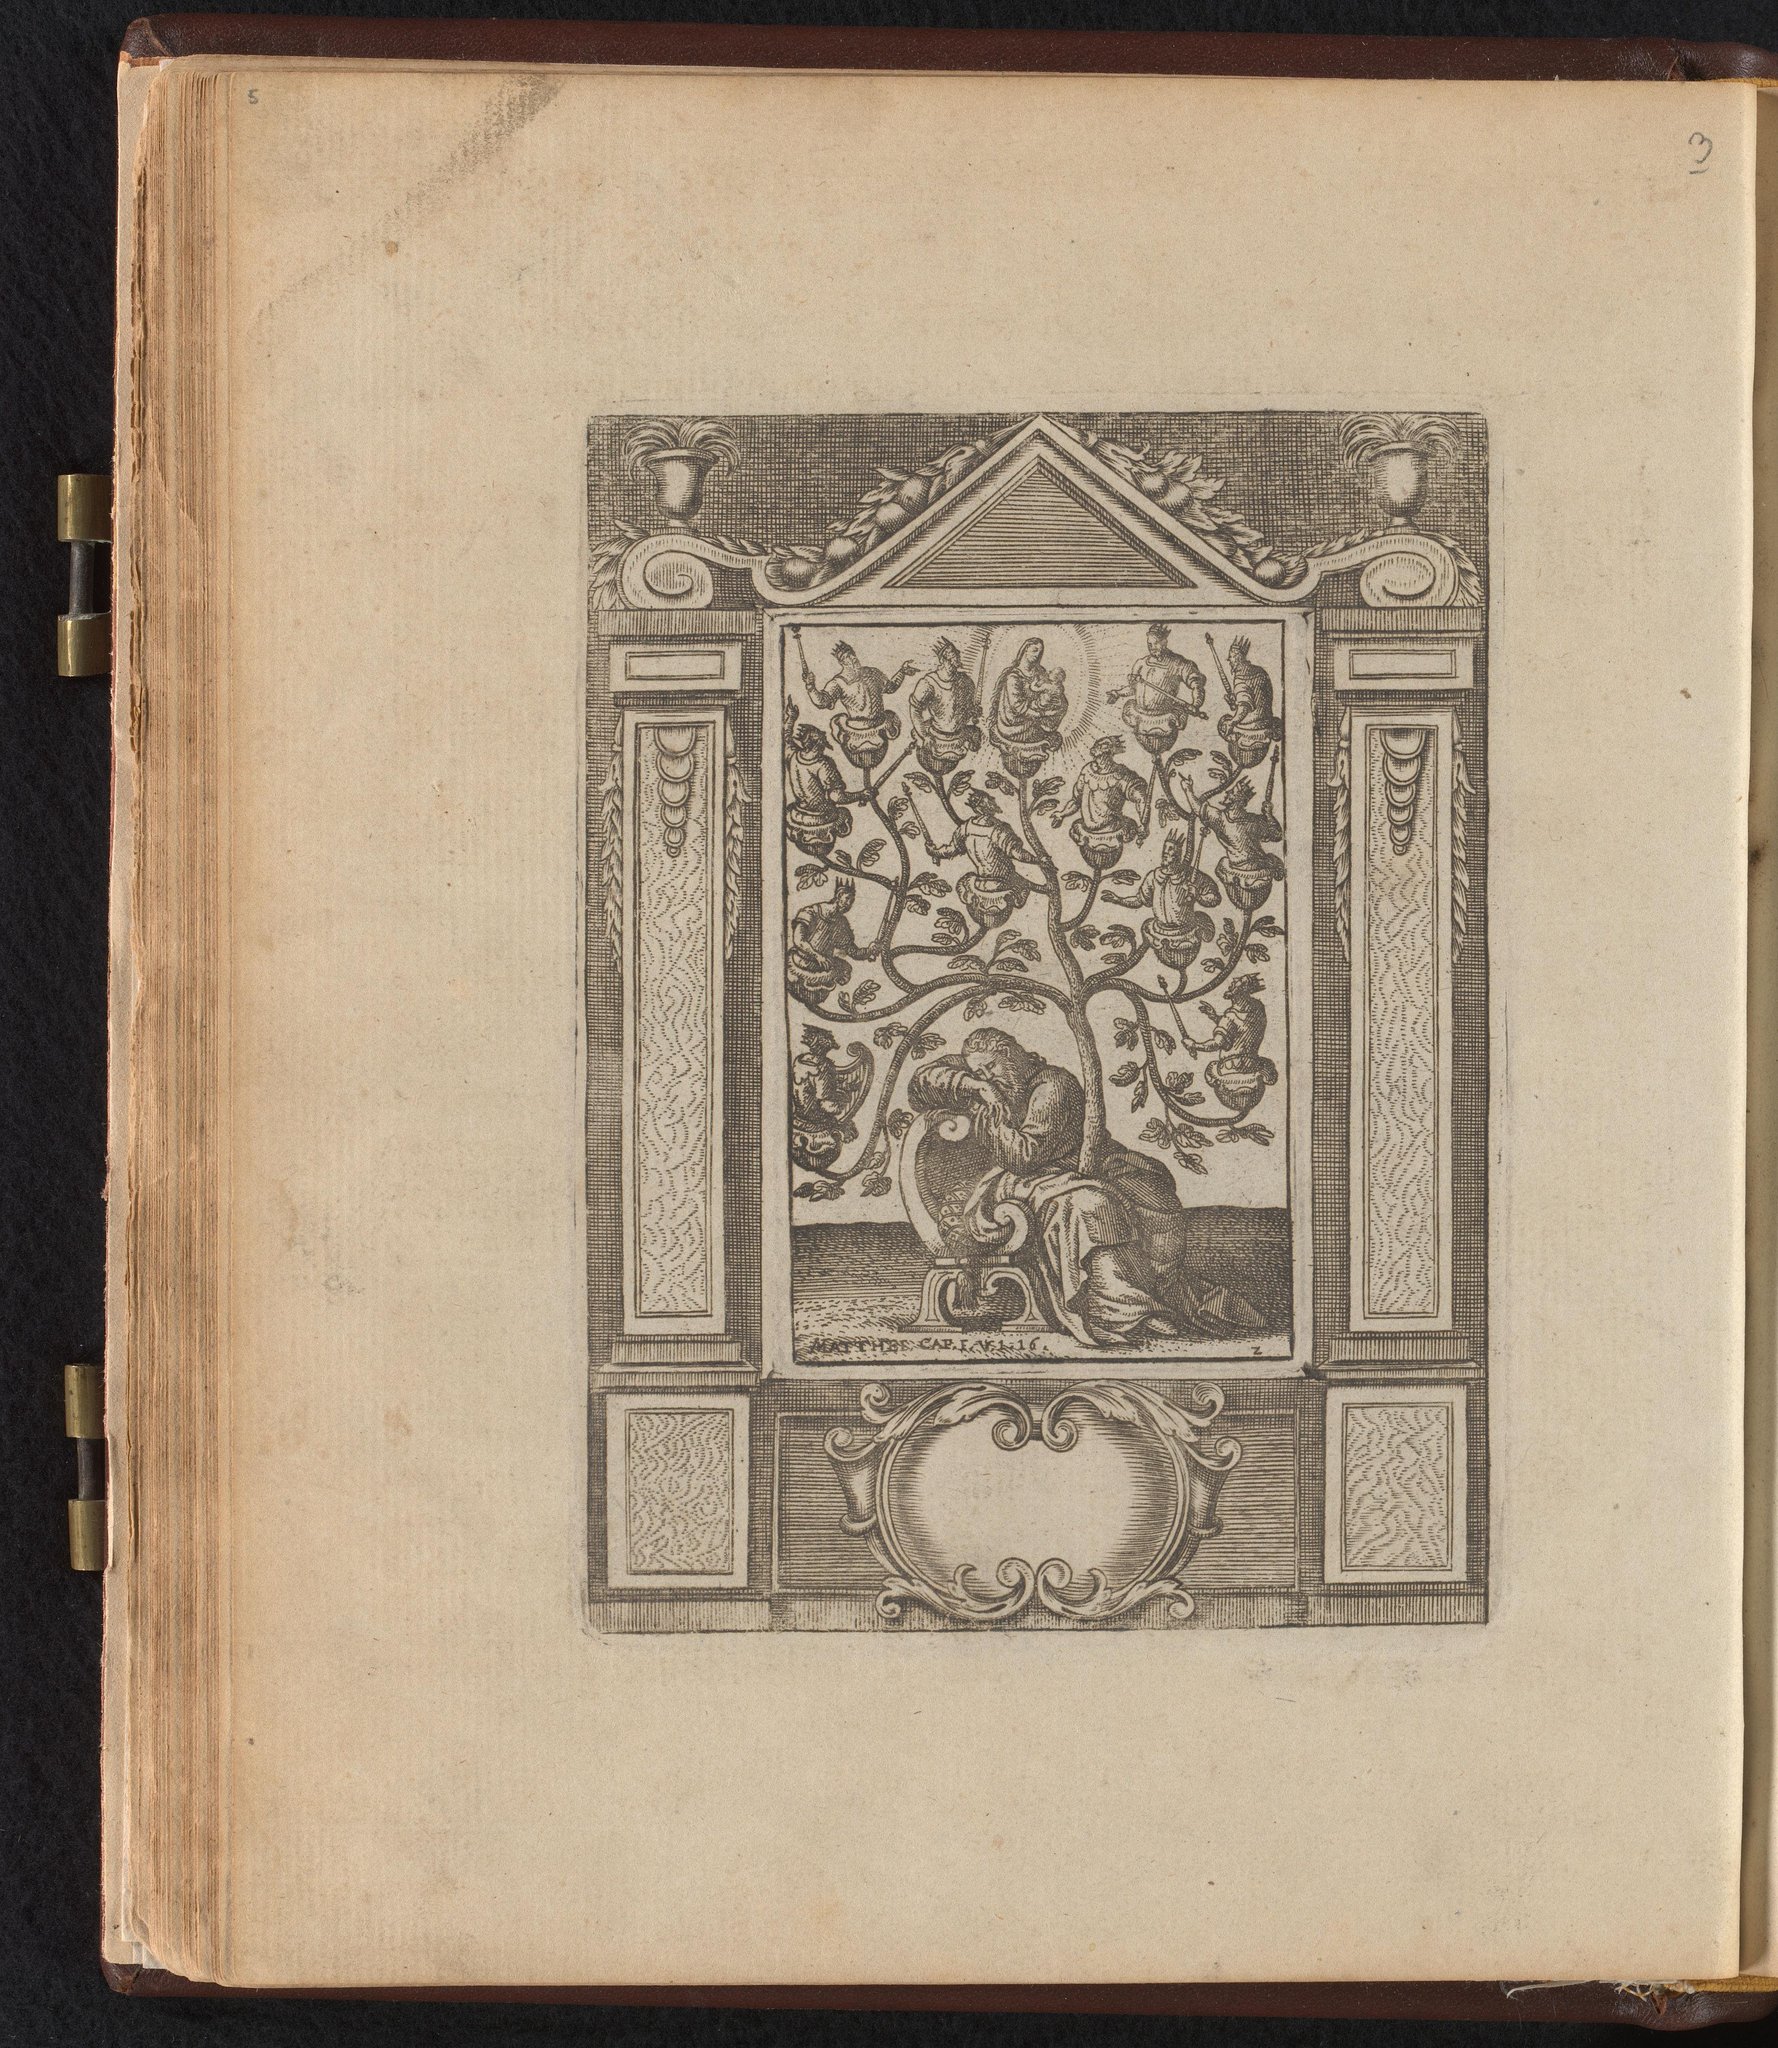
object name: print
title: Boom van Jesse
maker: Anonymous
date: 1783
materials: paper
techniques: engraving, etching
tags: tree of jesse: genealogical tree showing christ's ancestors, sprouting from jesse's loins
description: Prent in: s.n. Aldernouwkeurigste verhandelinge der geschiedenissen van het Nieuw Testament (...). Antwerpen: Cornelis Marten Spanoghe, 1783, p. 14-15.